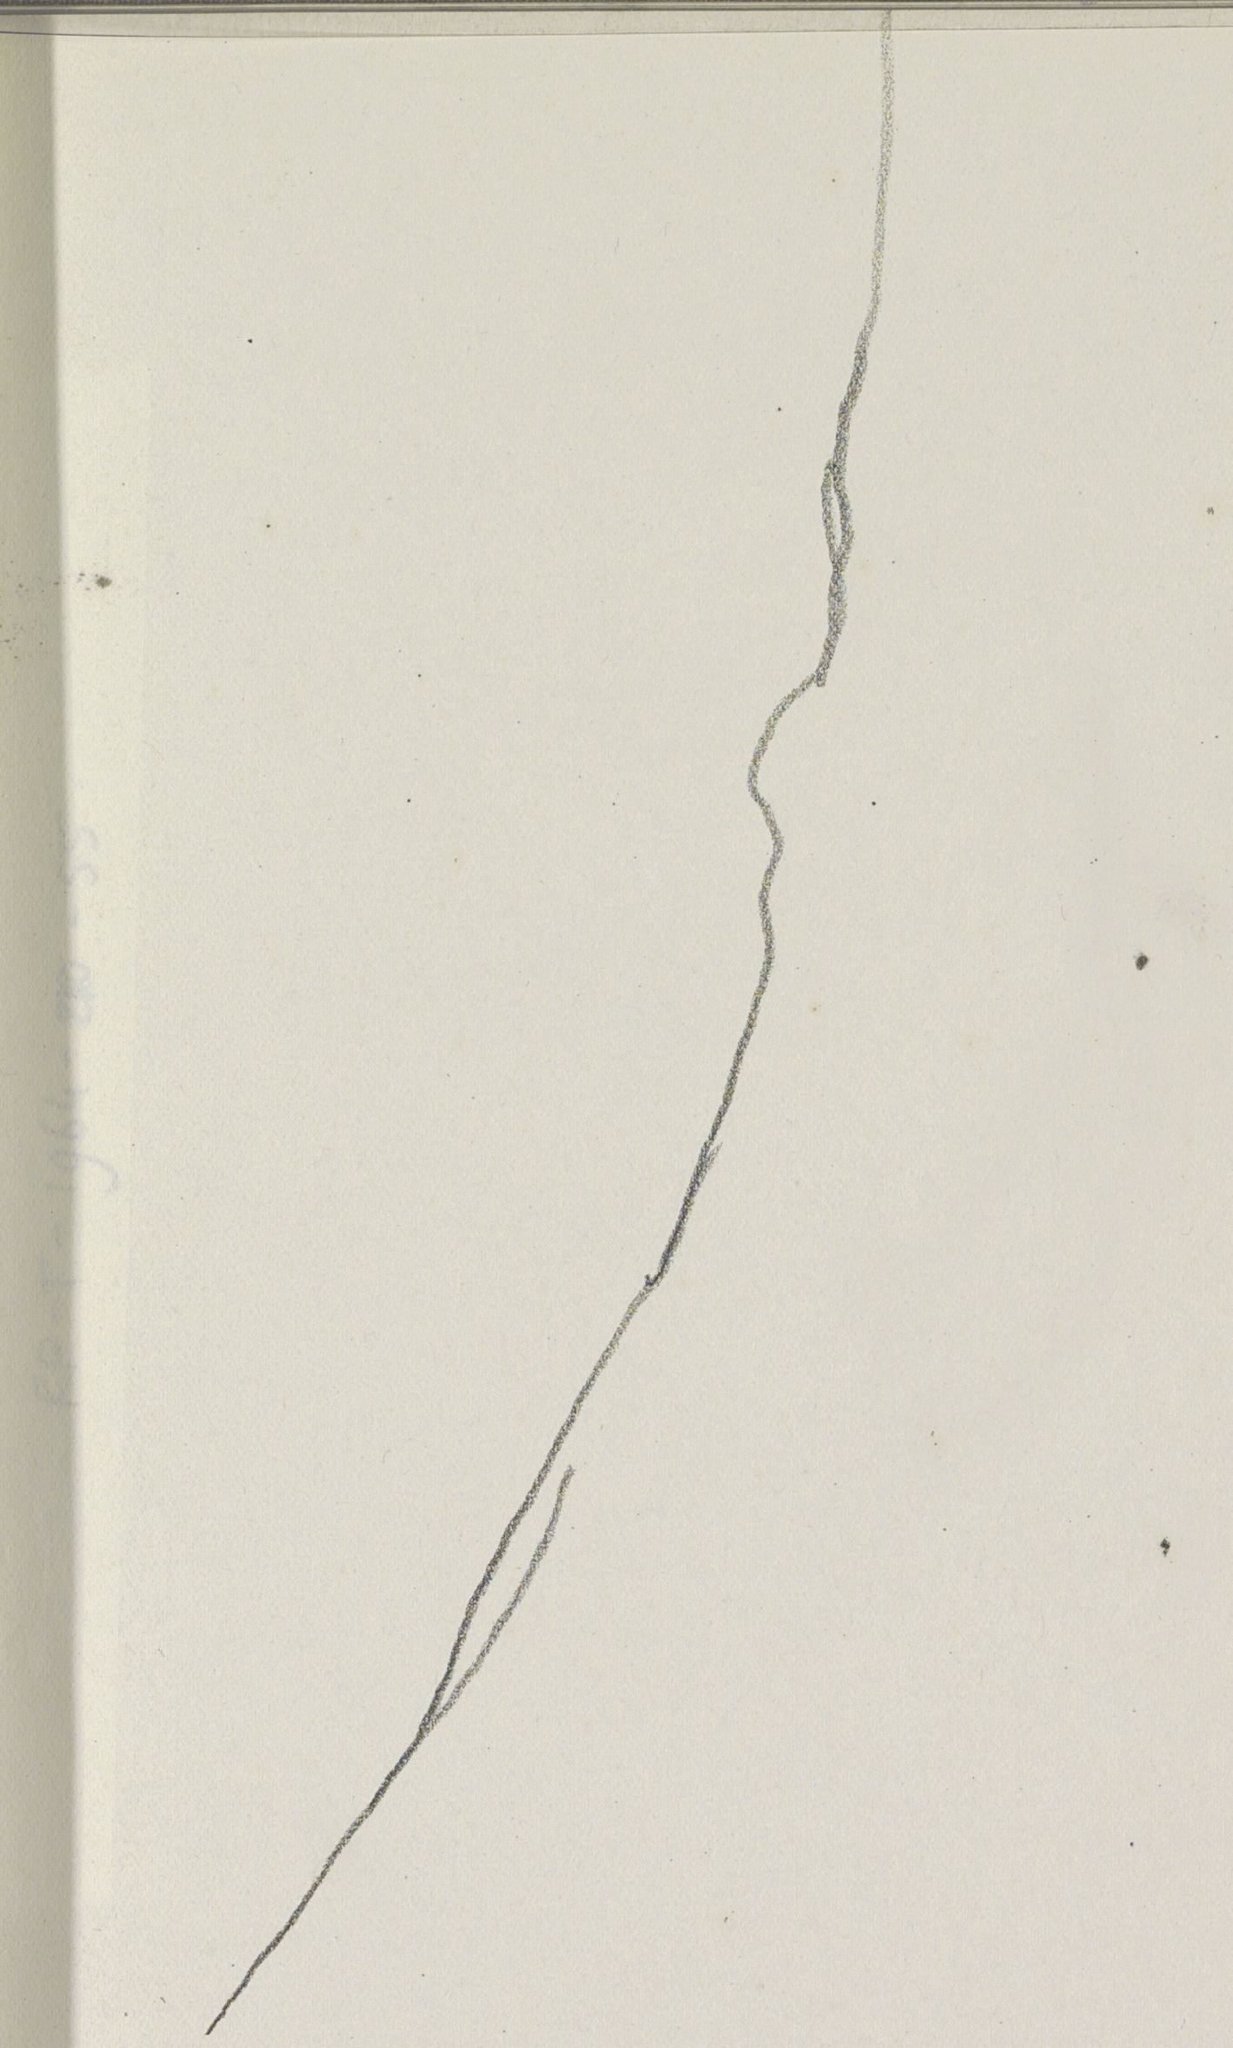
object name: sketchbook leaf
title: Studie, mogelijk van een landschap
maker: willem witsen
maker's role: draughtsman, painter, print maker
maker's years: 1860-1923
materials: paper, pencil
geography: dutch east indies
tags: landscapes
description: Blad 54 uit een schetsboek met 75 bladen vervaardigd te Nederlands-Indië.